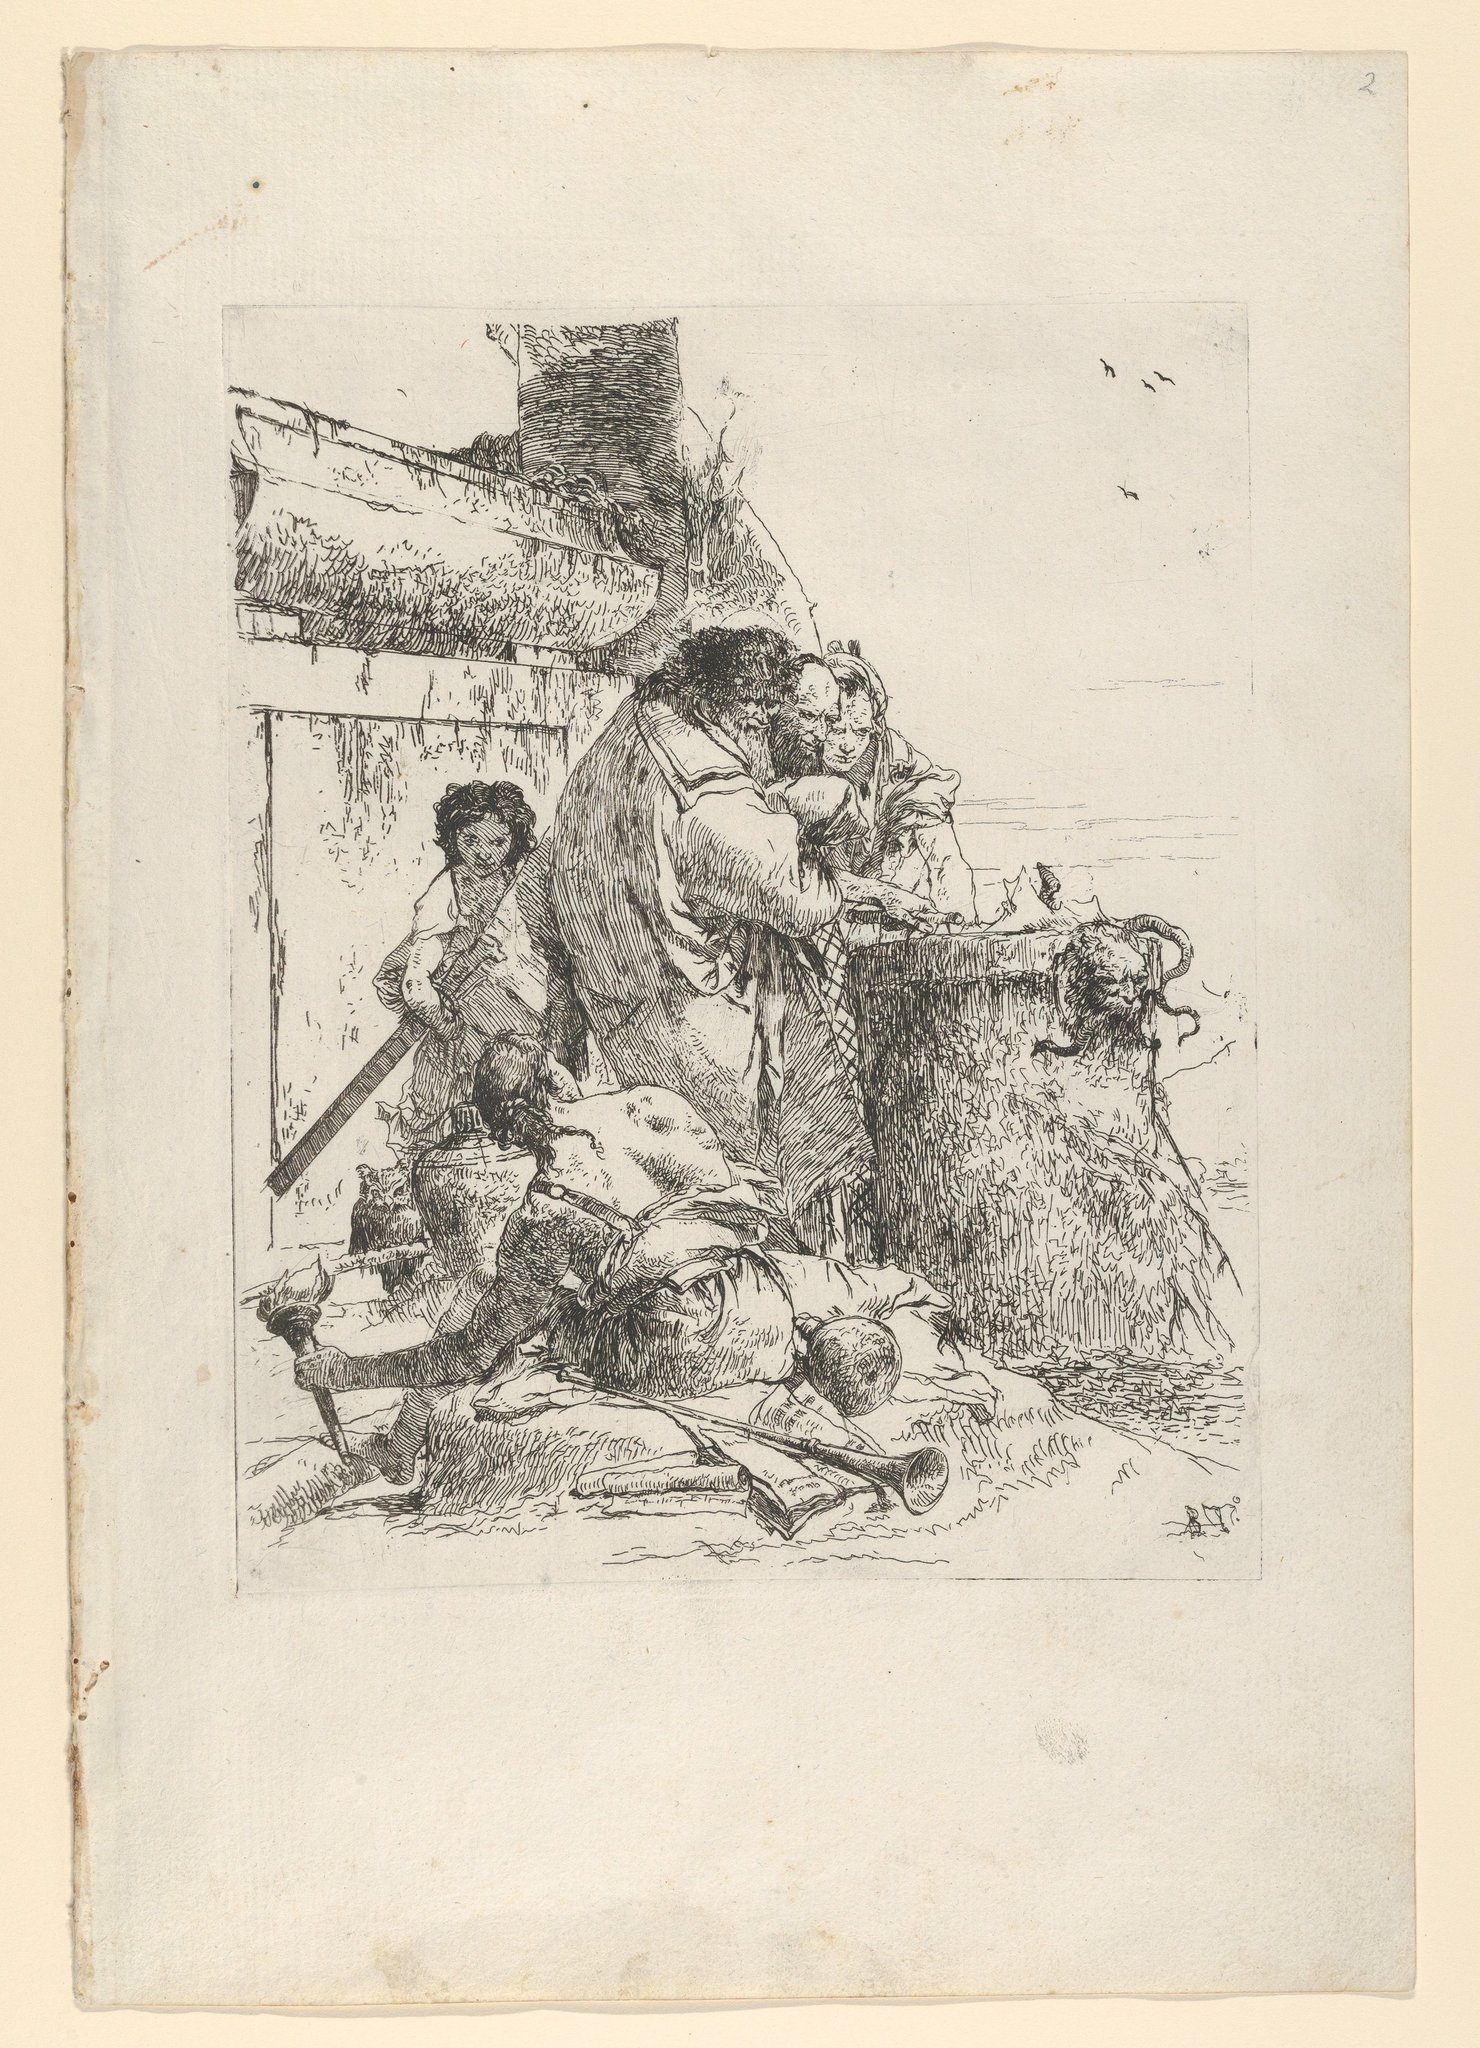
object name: print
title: Three magicians burning a snake, from the Scherzi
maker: giovanni battista tiepolo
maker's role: artist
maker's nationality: italian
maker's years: 1696-1770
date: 1743-1750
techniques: etching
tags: musical instruments,girls,men,snakes,magicians